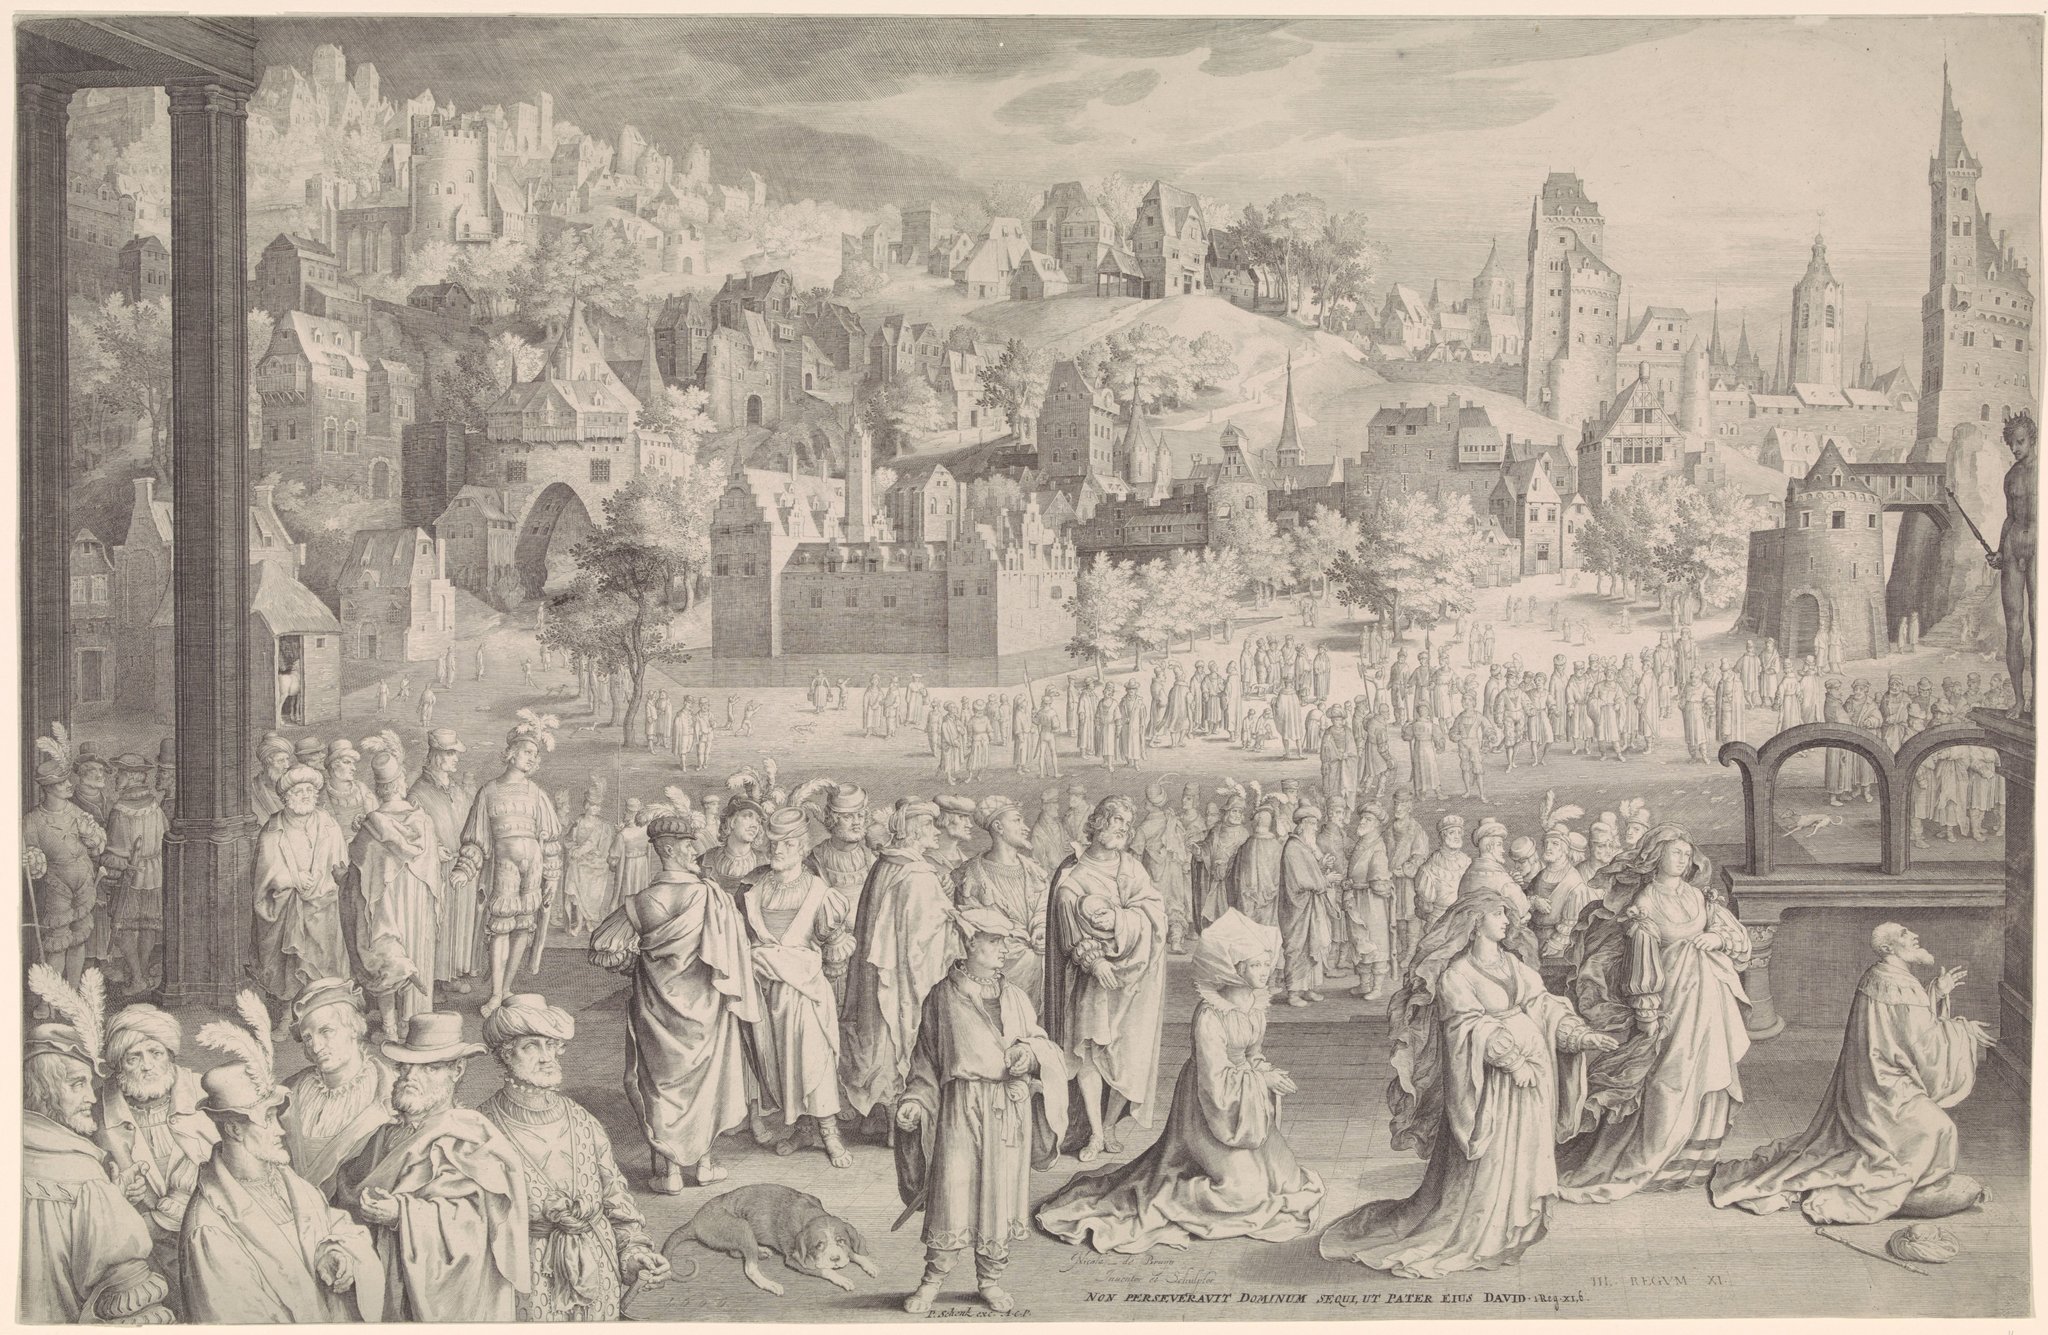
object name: print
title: Afgoderij van Salomo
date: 1606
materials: paper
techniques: engraving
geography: amsterdam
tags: solomon's idolatry, city-gate (+ city(-scape) with figures, staffage)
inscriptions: date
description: Salomo zit geknield voor een afgodsbeeld dat op een sokkel staat. Achter hem zijn vrouwen die hem tot afgoderij hebben verleid en de rest van zijn hofhouding. Op de achtergrond een stadsgezicht. De prent heeft een Latijns onderschrift uit de Bijbel (1. Kon. 11:6).